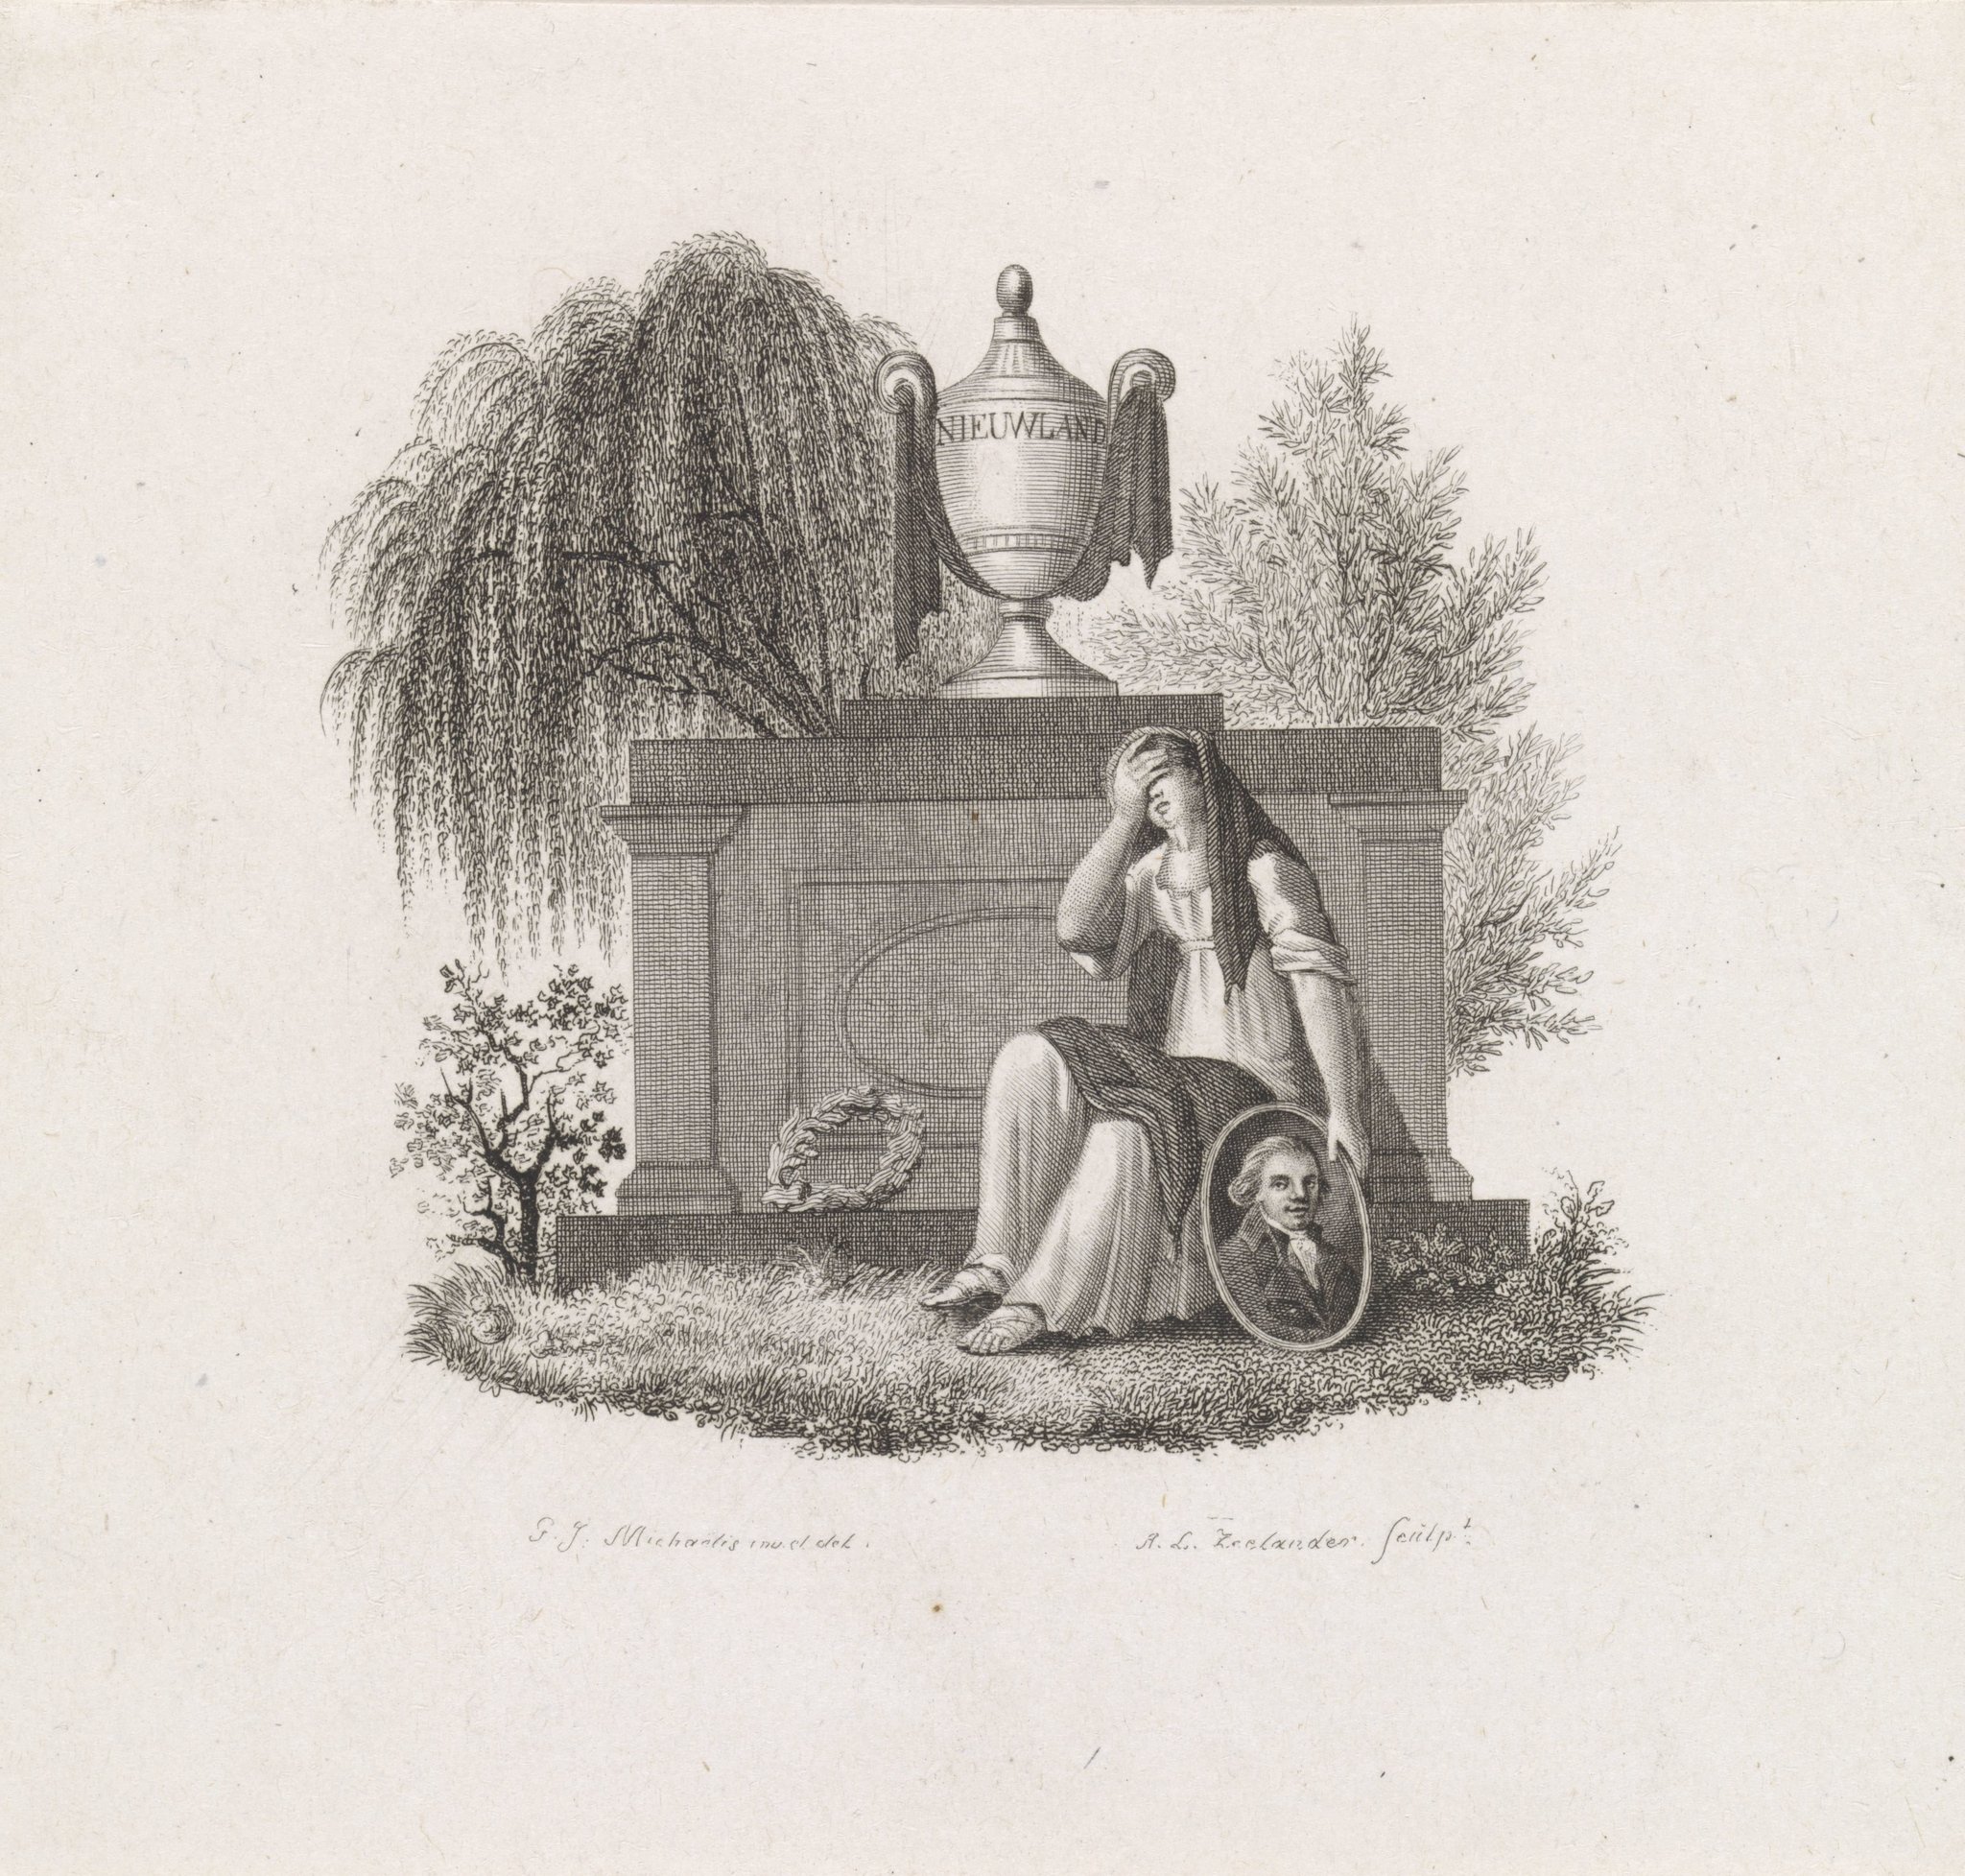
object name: print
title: Gedenkteken voor Pieter Nieuwland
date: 1799-1856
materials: paper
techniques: engraving, etching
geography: amsterdam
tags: grave, tomb and other grave-forms and grave-markers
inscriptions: collector's mark: Lugt 2228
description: Een gedenkteken ter nagedachtenis van hoogleraar in de wis- en natuurkunde Pieter Nieuwland. Een vrouw zit treurend onder het monument met het portret van Pieter Nieuwland in de hand.